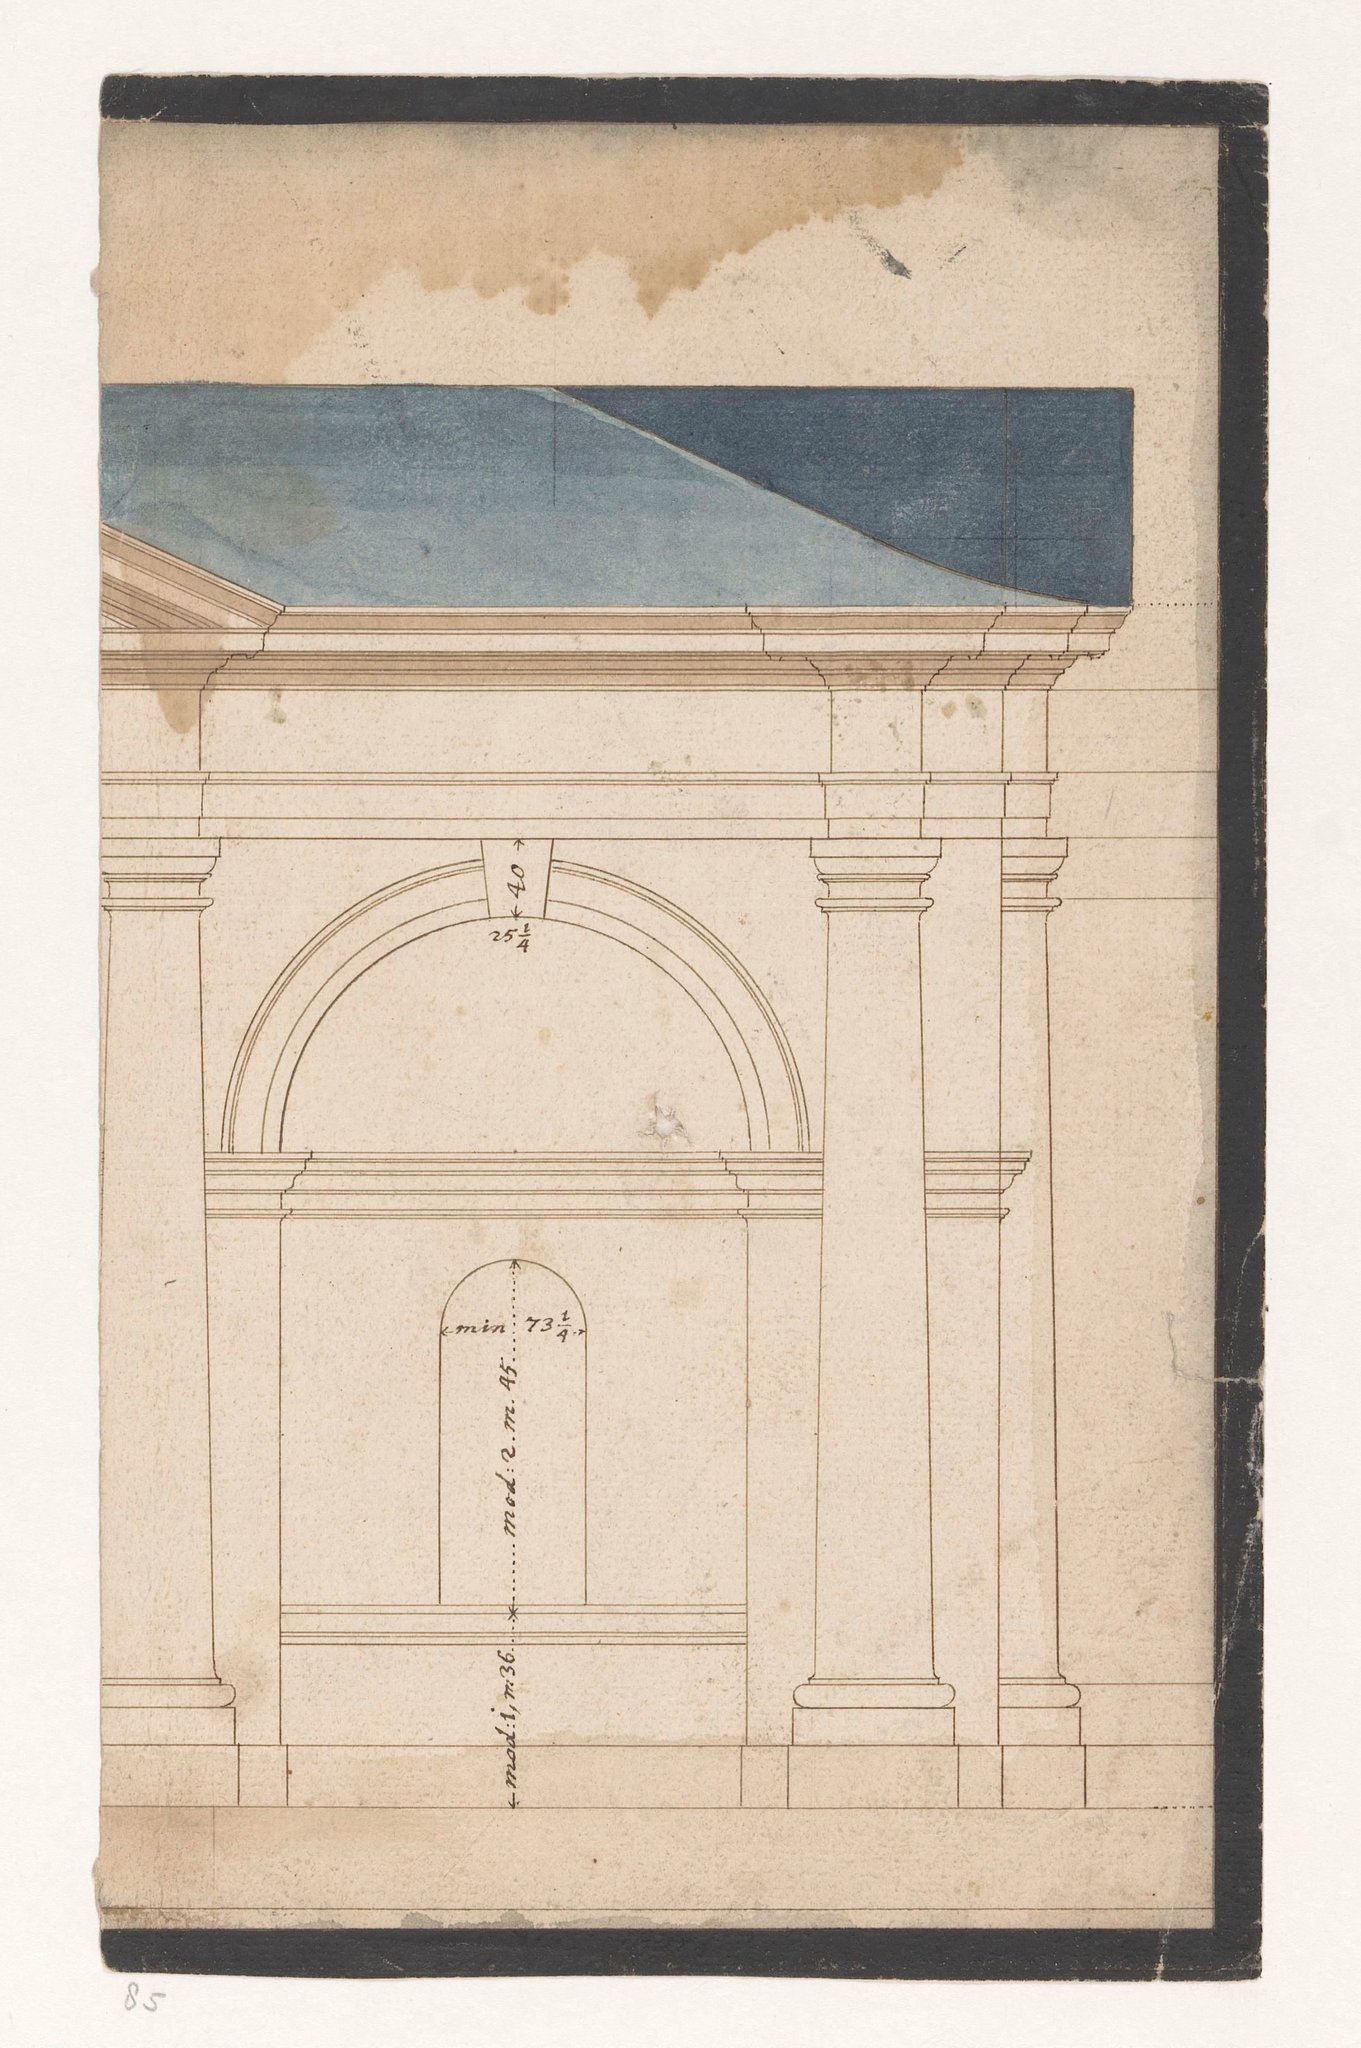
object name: drawing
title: Architectuurtekening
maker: jan brandes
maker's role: draughtsman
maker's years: 1743-1808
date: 1770-1808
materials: paper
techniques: brush, pen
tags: architectural design or model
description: Architectuurtekening van een deel van de gevel van een neoklassiek gebouw. Zwart kader om driekwart van de tekening.